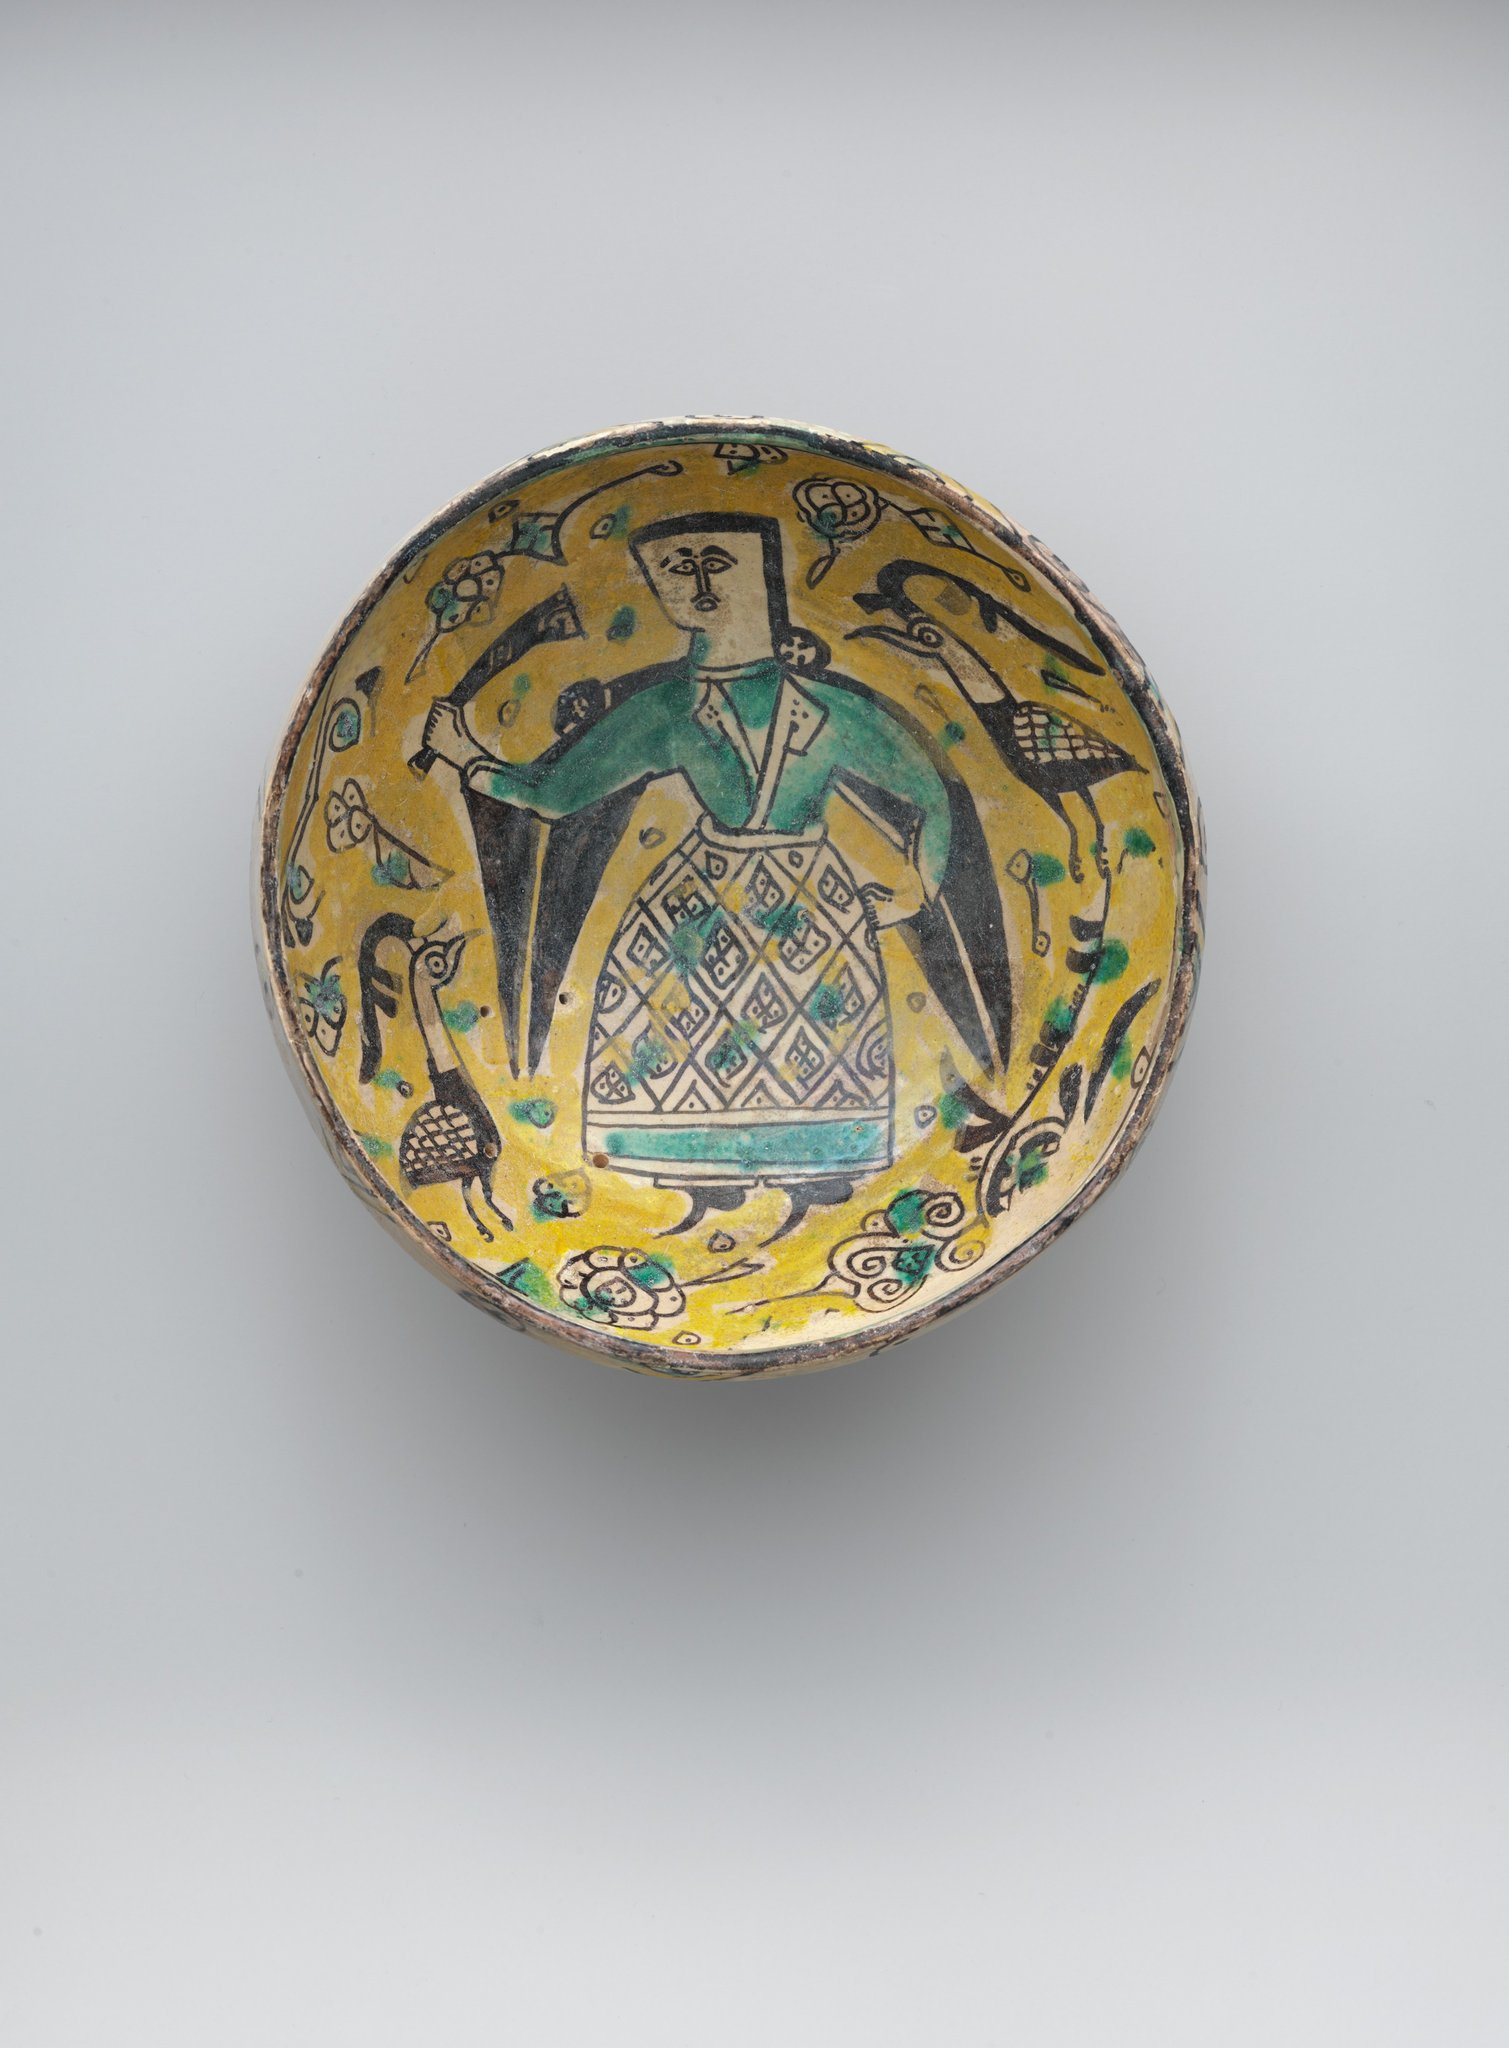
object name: bowl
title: Bowl with a Figure and Birds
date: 901-1000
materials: earthenware, glaze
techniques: polychrome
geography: iran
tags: birds,men